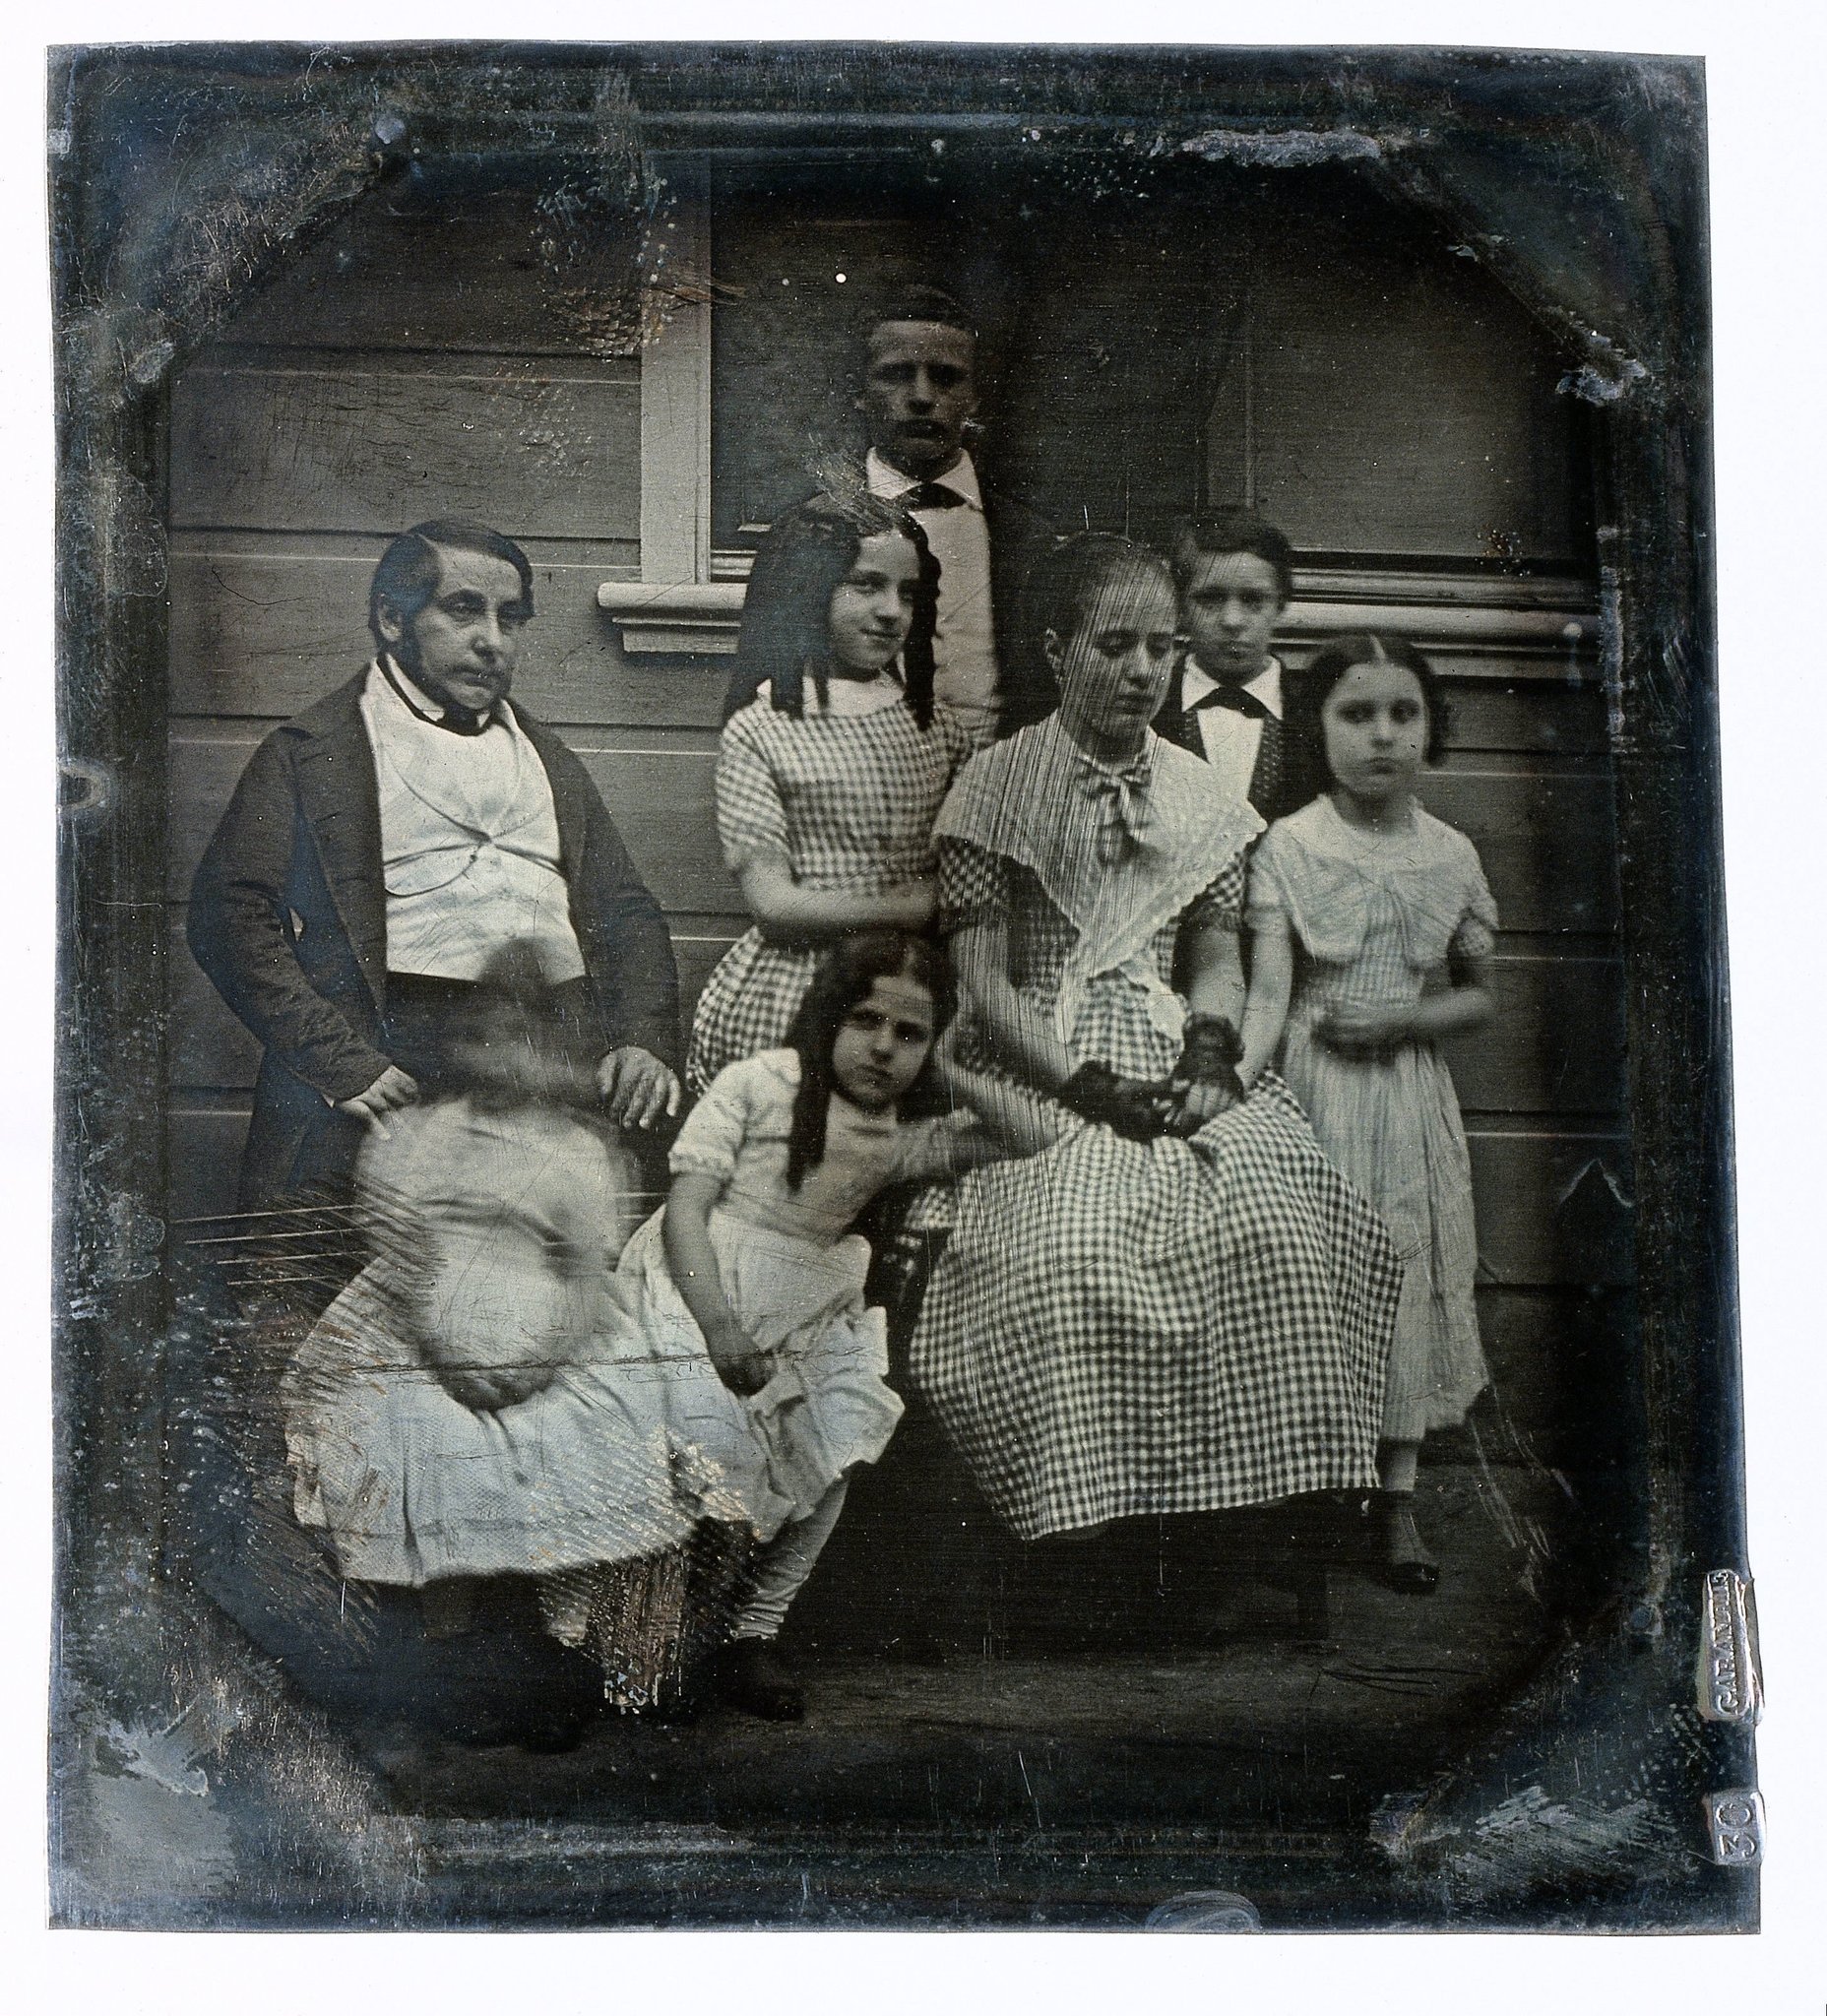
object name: photograph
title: Groepsportret van leden van de familie Asser en Oppenheim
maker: eduard isaac asser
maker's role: amateurfotograaf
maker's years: 1809-1894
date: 1847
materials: copper, glass, paper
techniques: daguerreotype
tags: family group, especially parents with their child(ren)